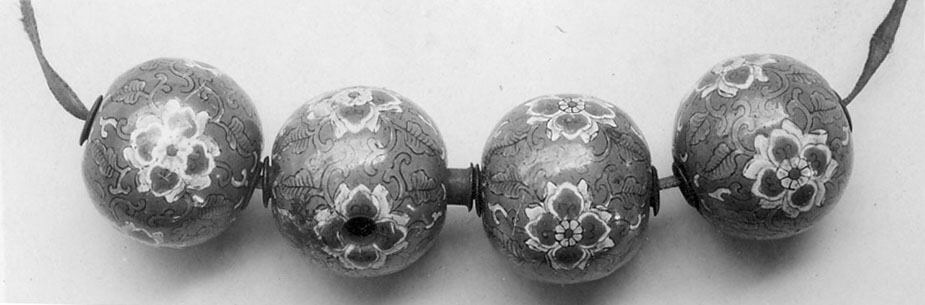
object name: bead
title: Beads (four)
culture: chinese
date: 1801-1900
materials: enamel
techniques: painting